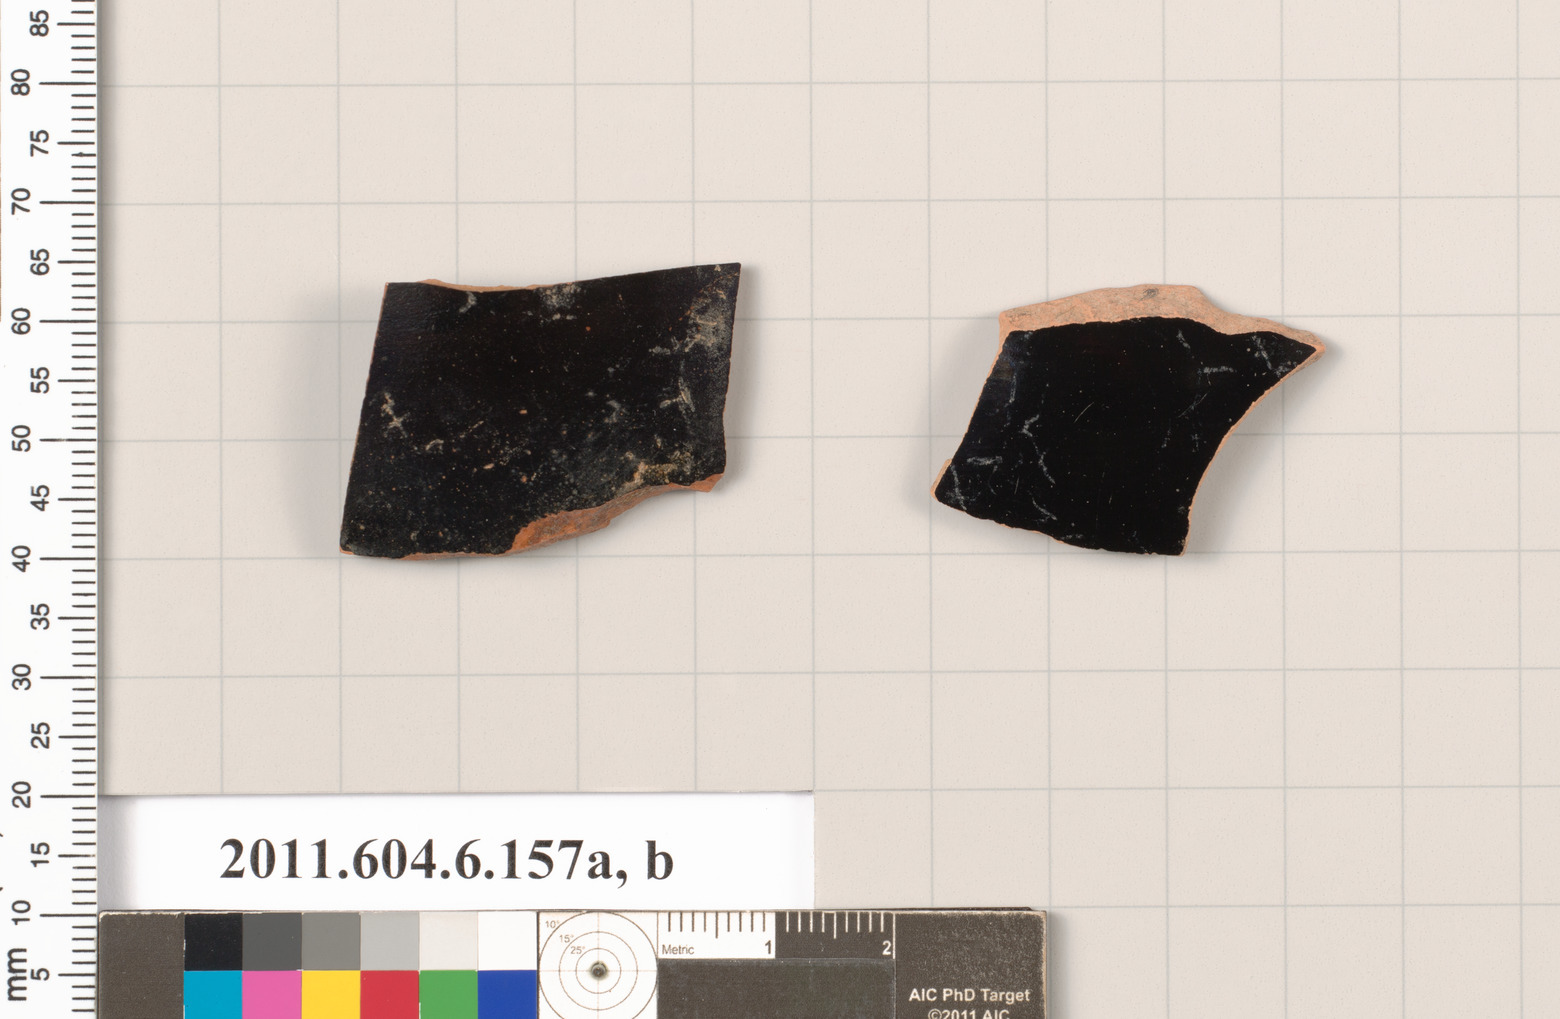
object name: undetermined open shape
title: Terracotta fragments of open shapes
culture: greek, attic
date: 600-401 BCE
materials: terracotta